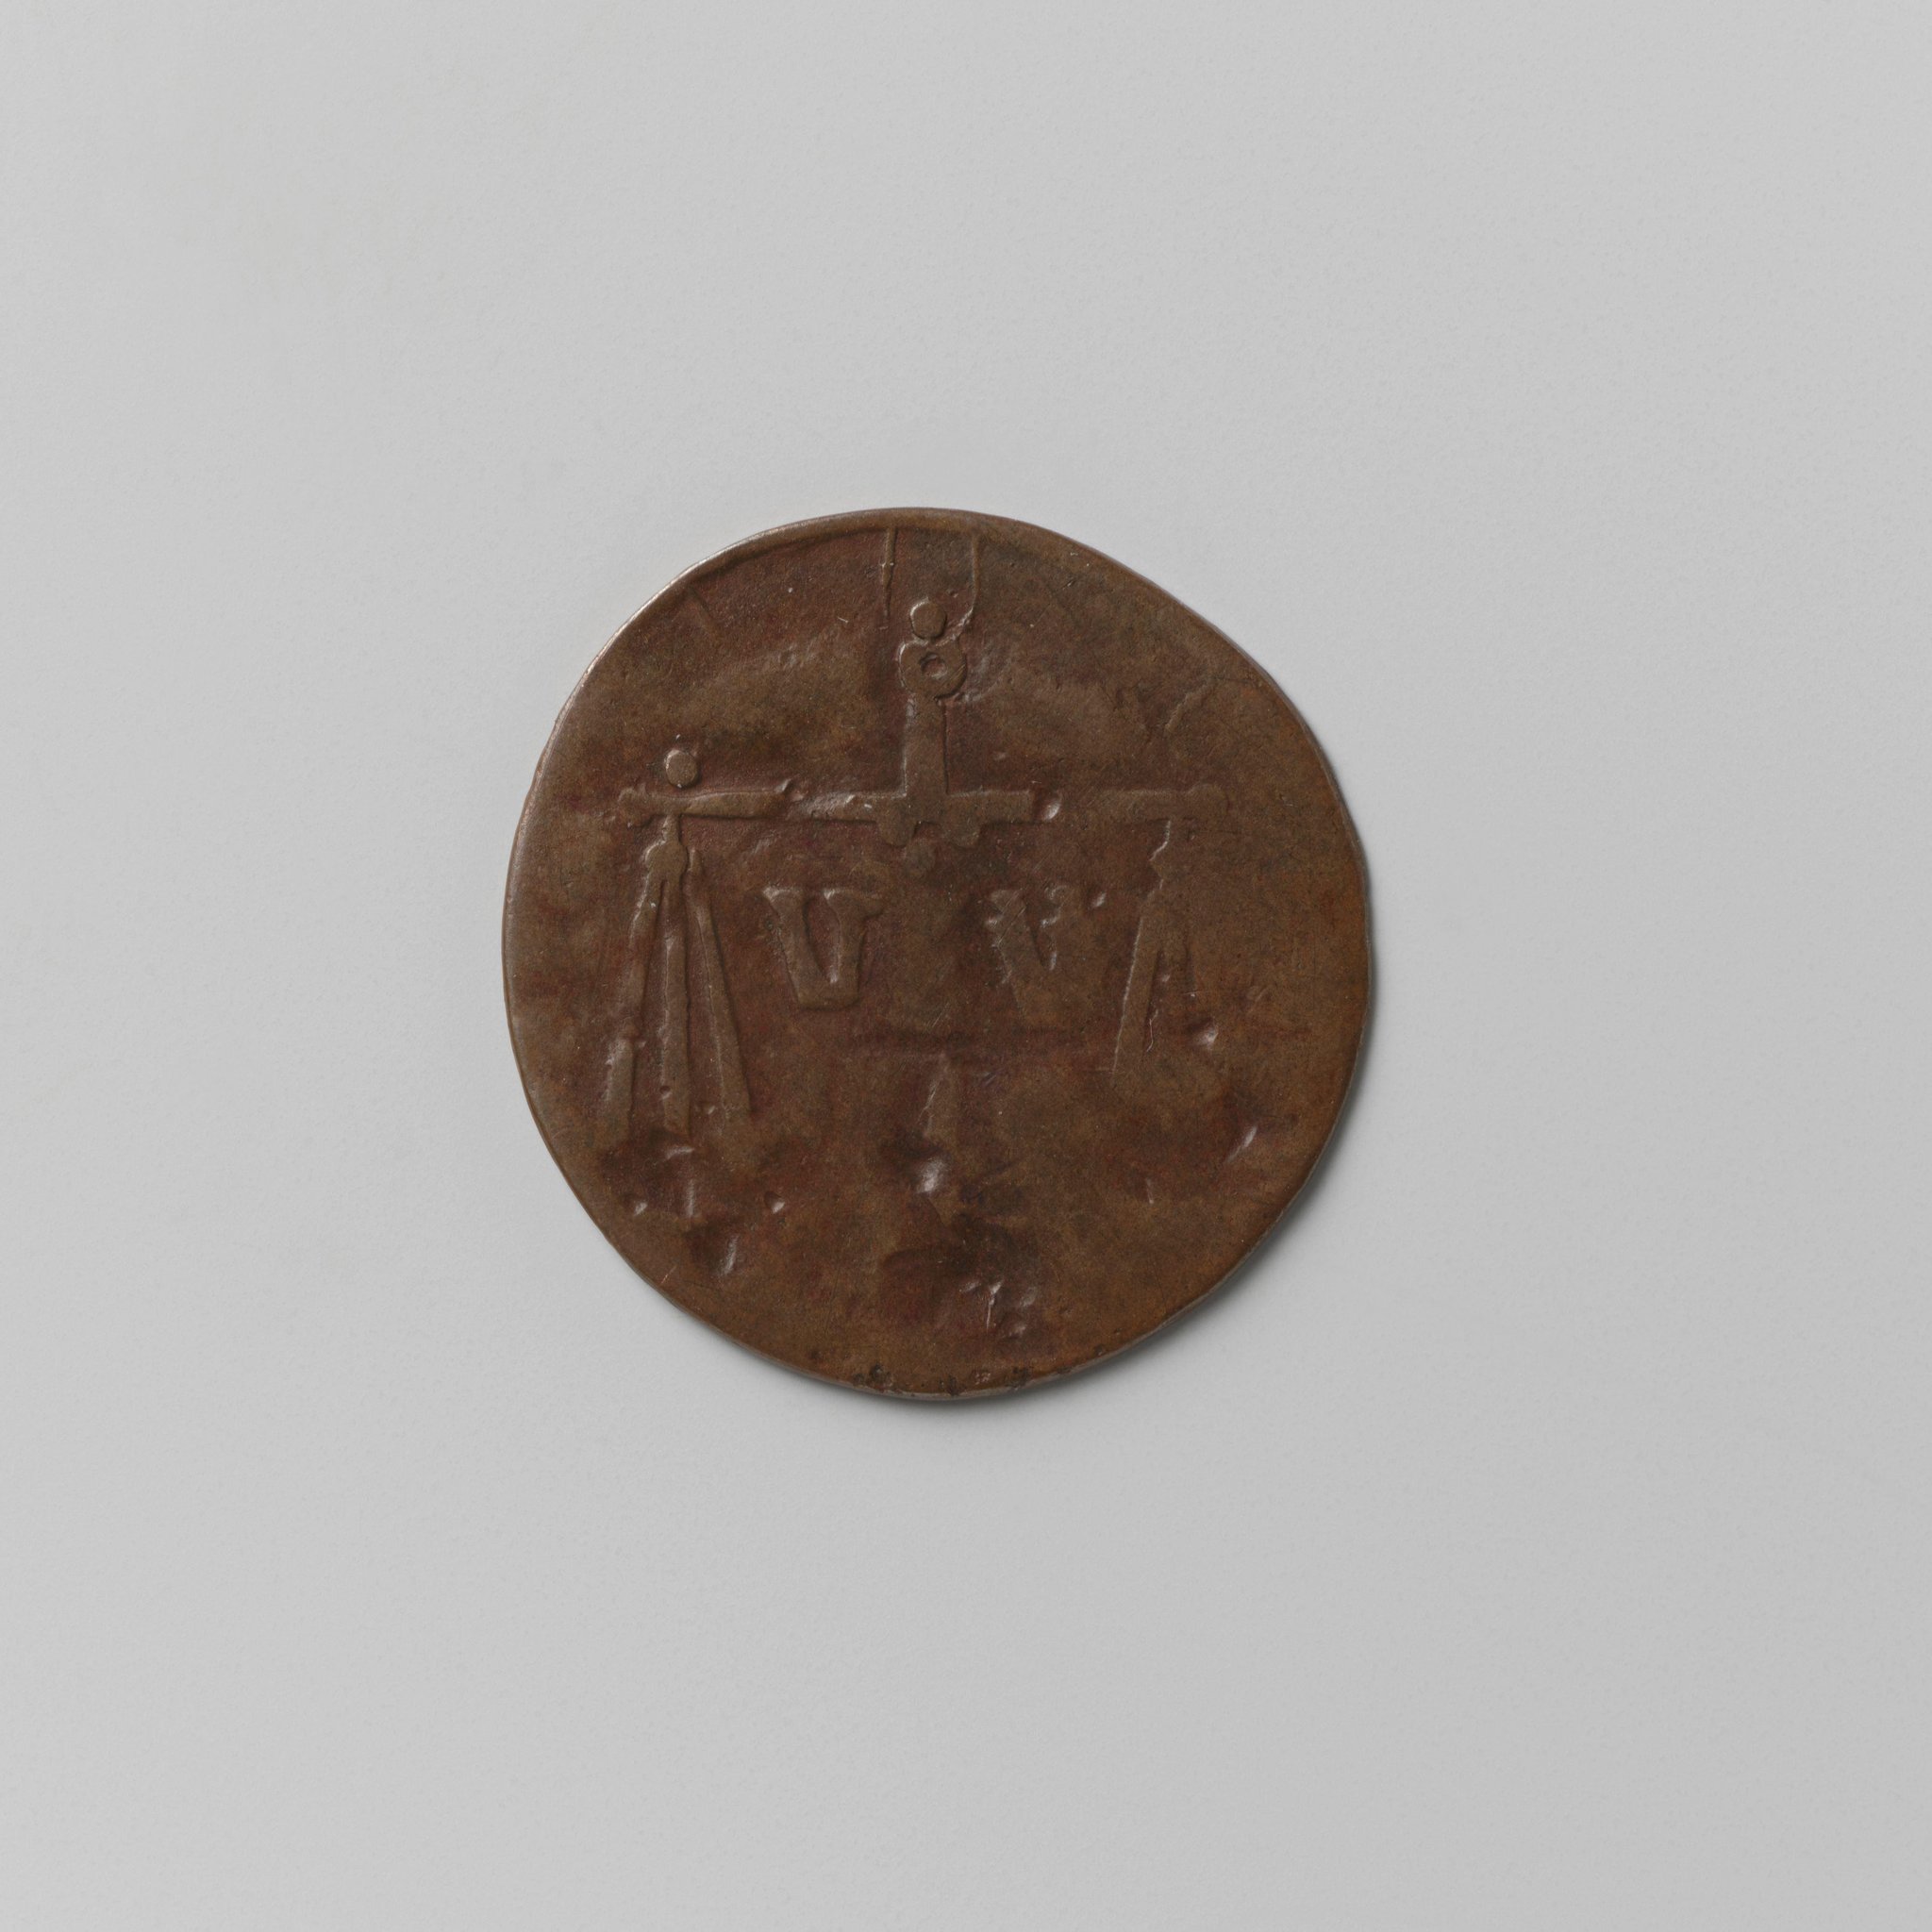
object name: coin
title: Nabootsing van een koperen munt uit Bombay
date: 1780-1830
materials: copper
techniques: striking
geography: banjarmasin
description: Koperen munt. Nabootsing van een koperen munt uit Bombay. Voorzijde: monogram van de Engelse Oost-Indische Compagnie. Keerzijde: weegschaal met eenregelig opschrift in Arabische letters: adil [=rechtvaardigheid].